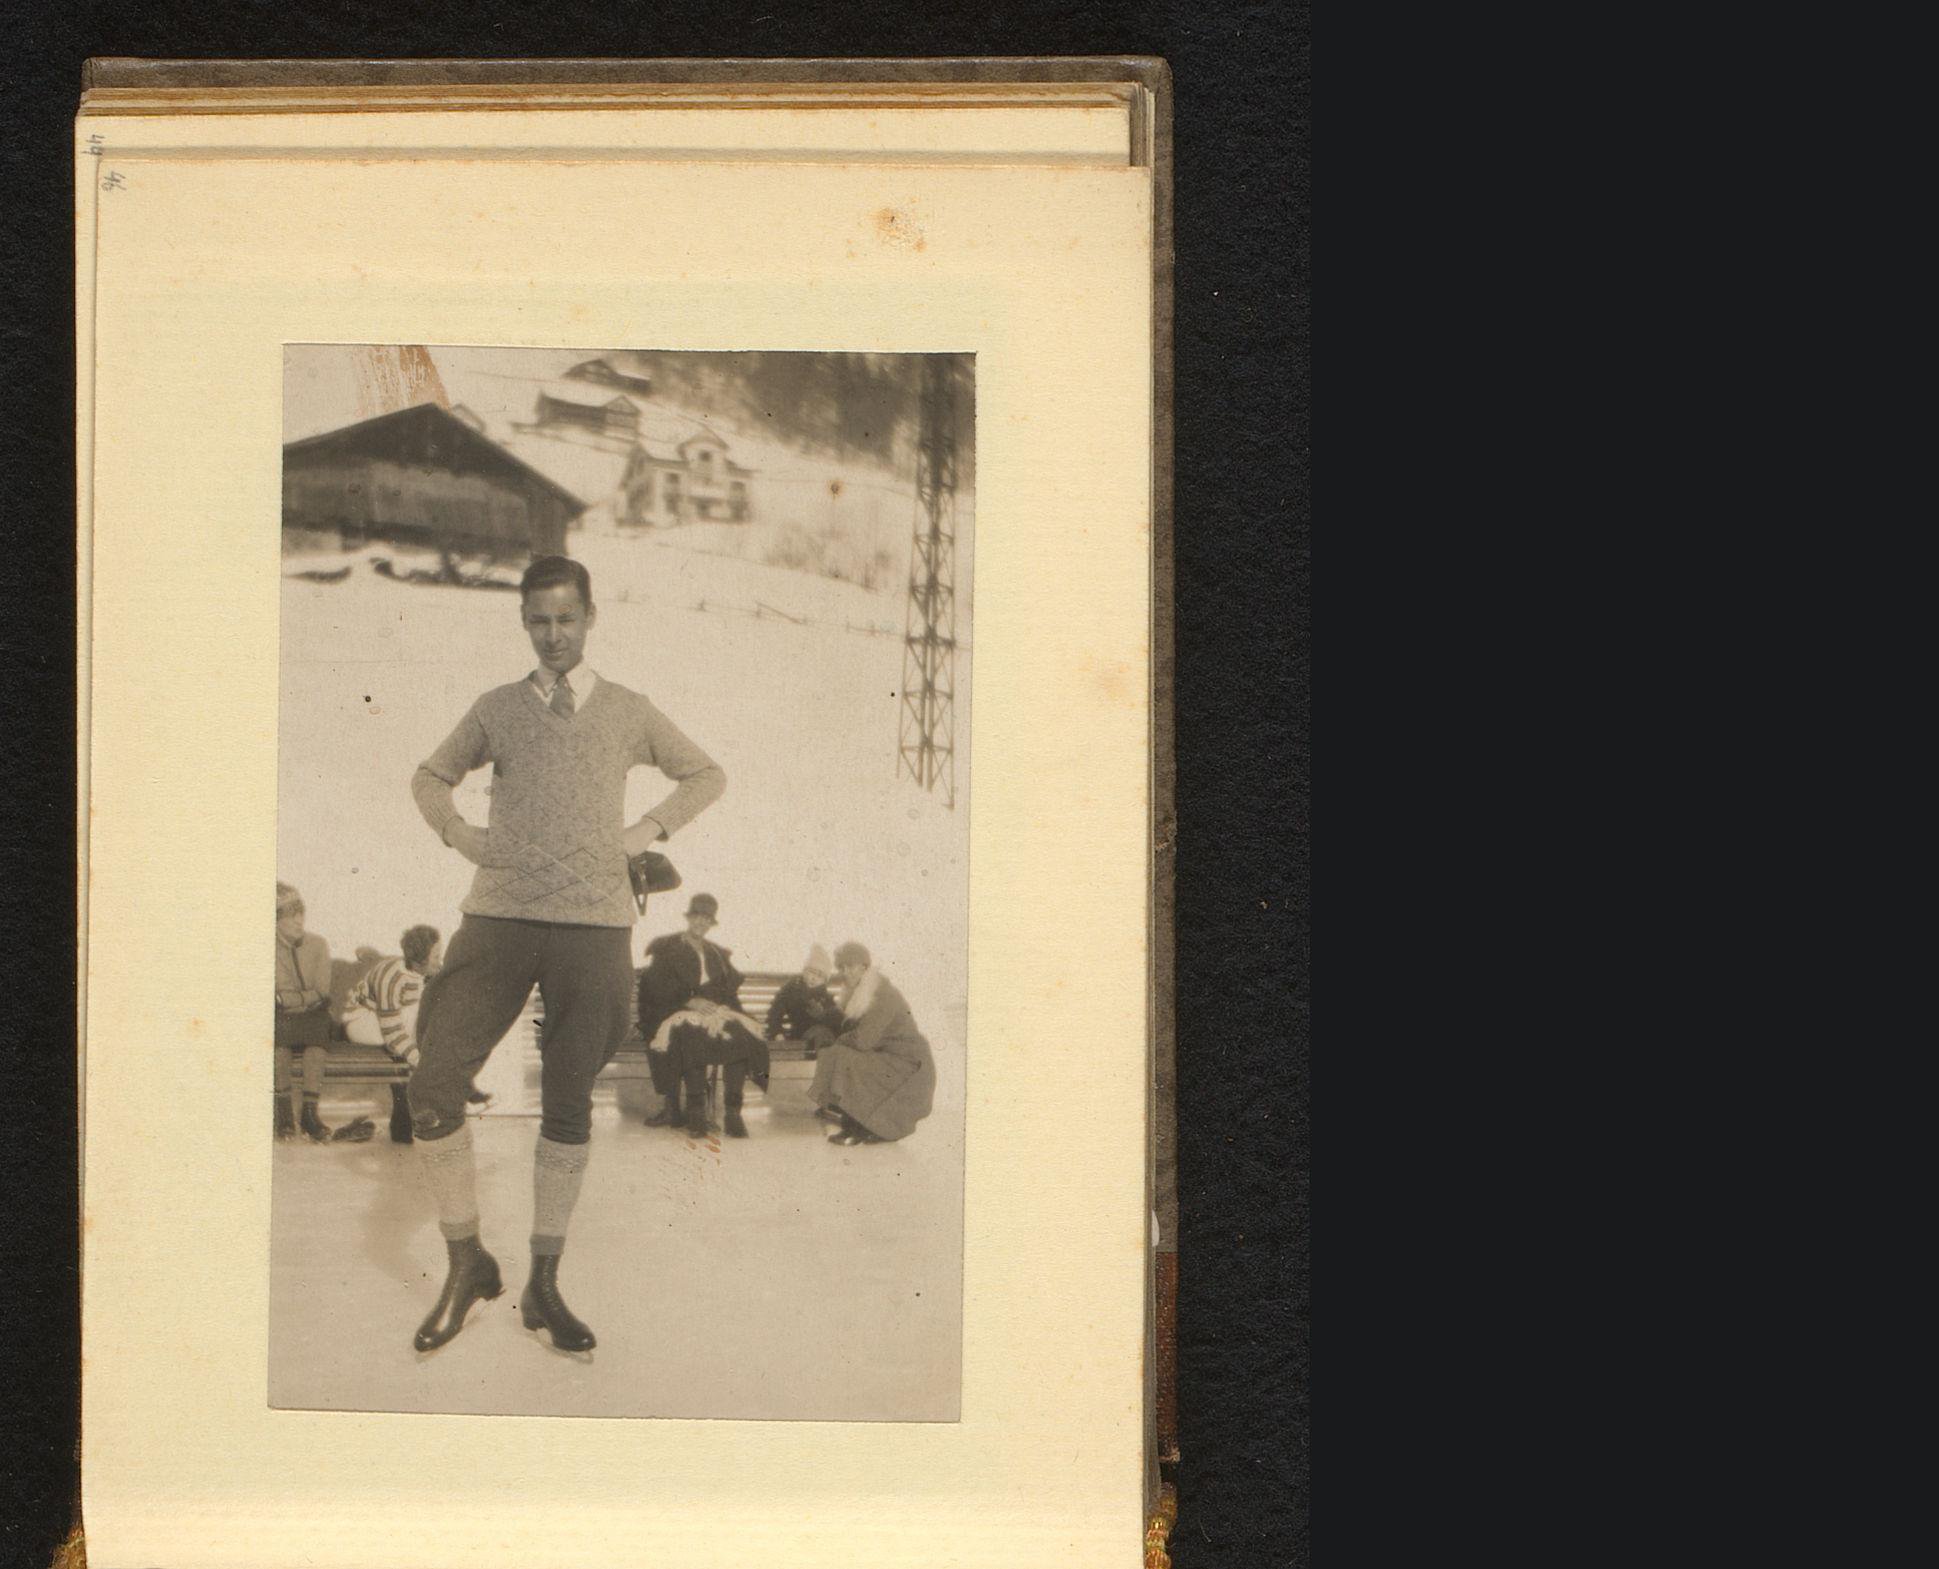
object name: photograph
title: Man op schaatsen in sneeuwlandschap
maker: norbert van den berg (1901-1972)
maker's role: amateurfotograaf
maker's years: 1901-1972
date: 1935-1950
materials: paper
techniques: gelatin silver print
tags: adult man, skates (winter sports), snow